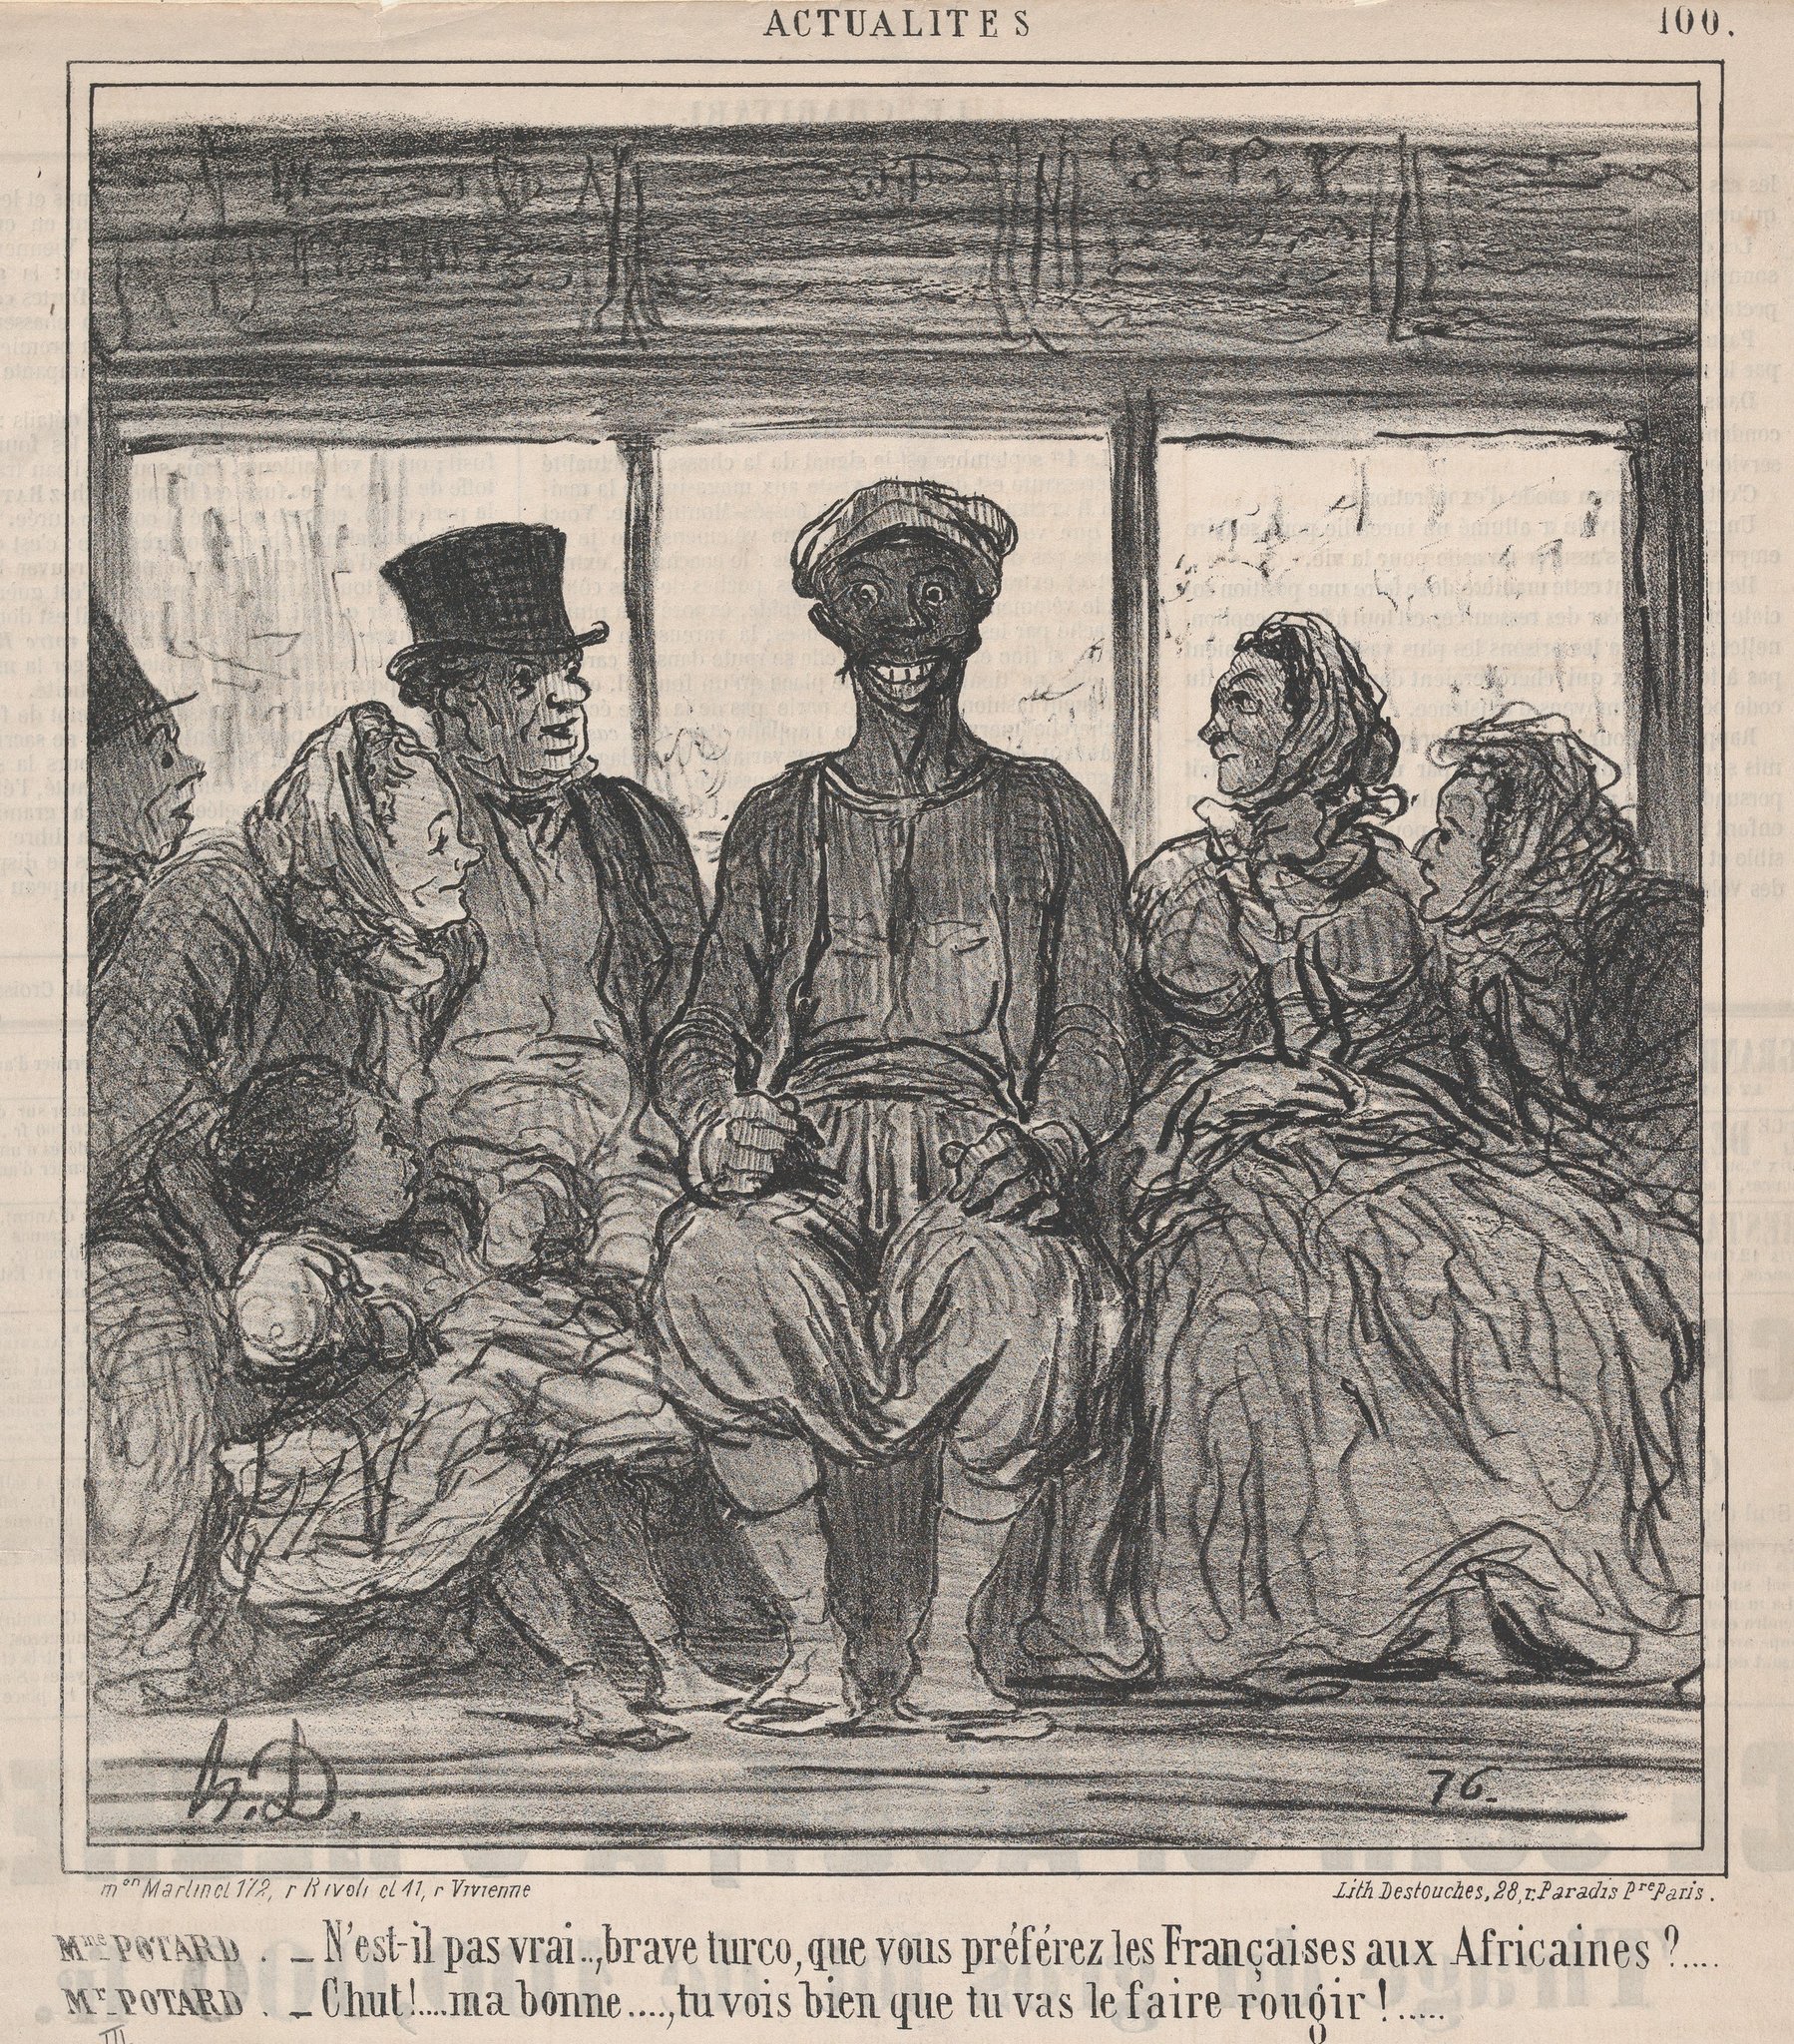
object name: print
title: N'est-il pas vrai, brave turco, que vous préférez les Françaises aux Africaines?..., from Les Actualités, published in Le Charivari, August 31, 1859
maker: honoré daumier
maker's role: artist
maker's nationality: french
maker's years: 1808-1879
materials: paper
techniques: lithograph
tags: children,men,women